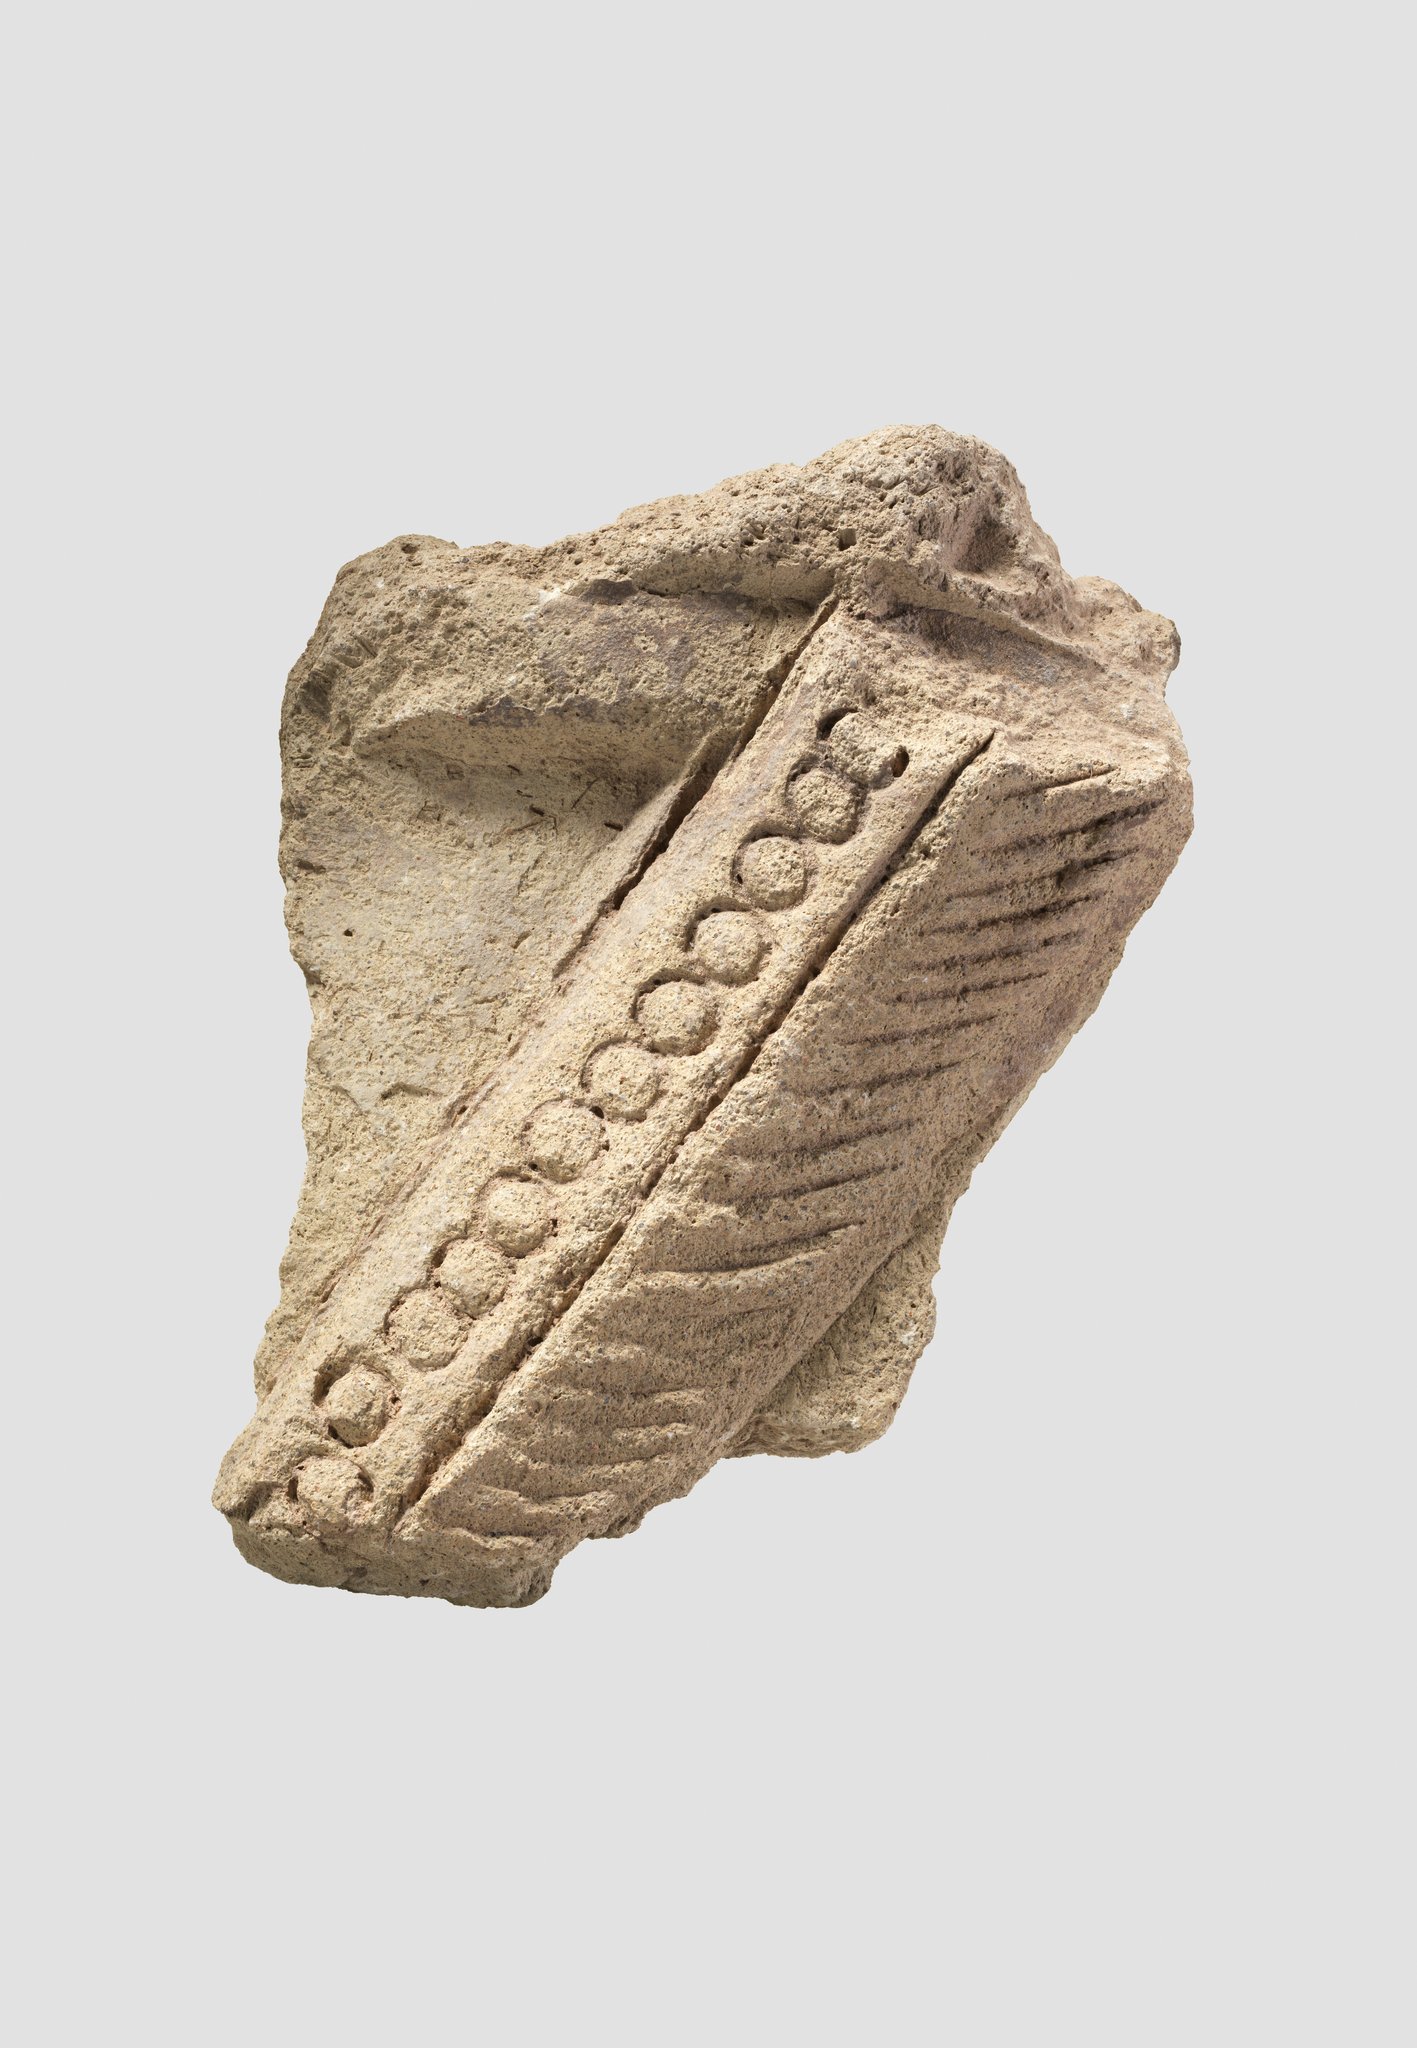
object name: sherd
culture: sasanian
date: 201-700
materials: ceramic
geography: mesopotamia